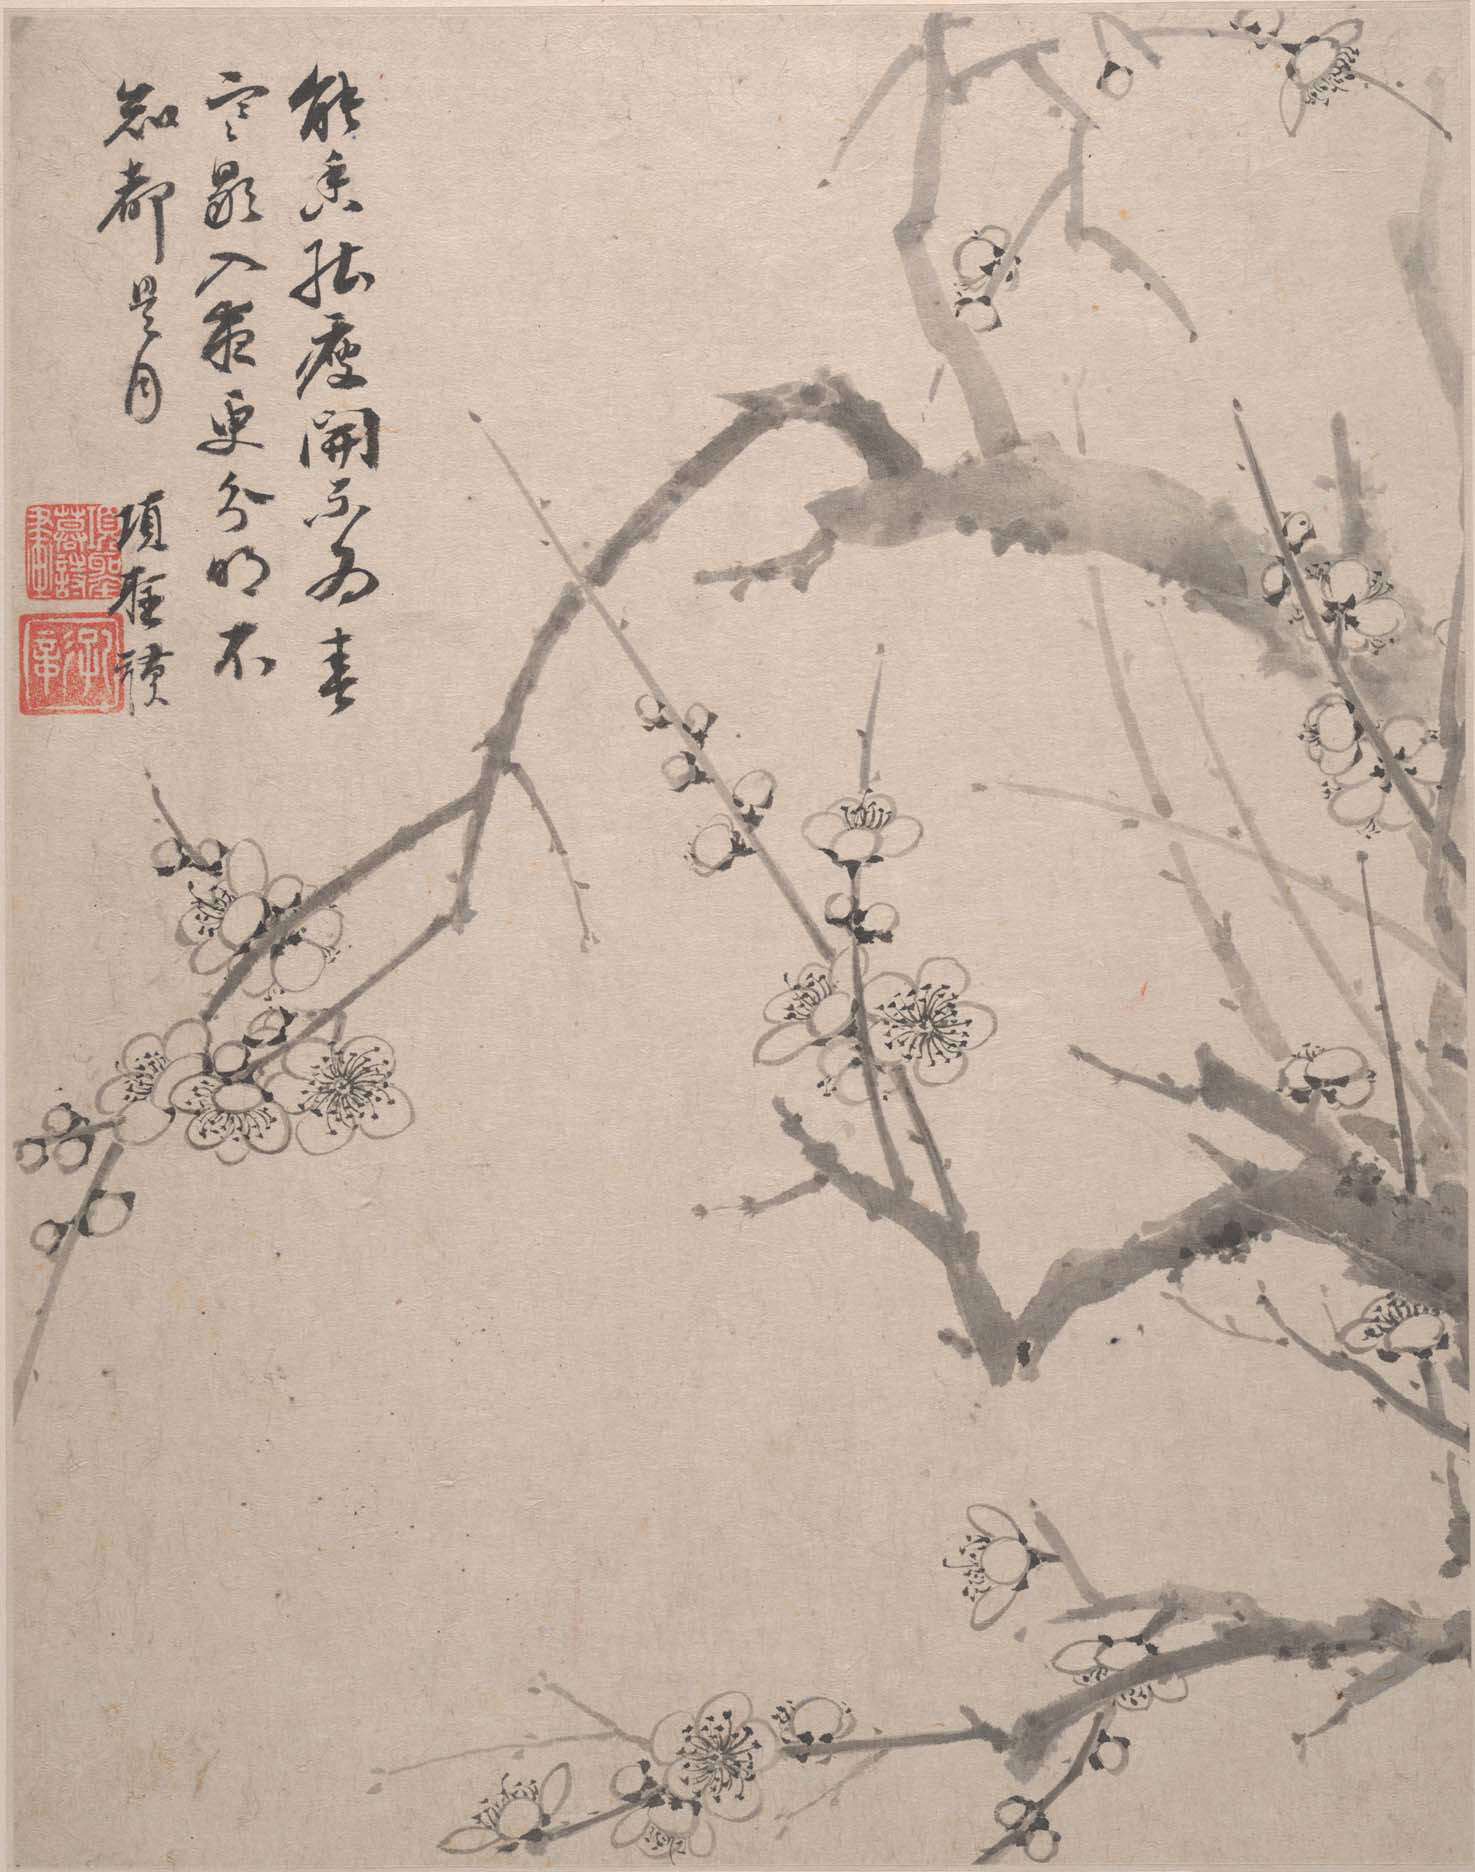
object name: album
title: Landscapes, Flowers and Birds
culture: chinese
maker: xiang shengmo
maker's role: artist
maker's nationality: chinese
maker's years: 1597-1658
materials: ink, paper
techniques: painting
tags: birds,flowers,landscapes